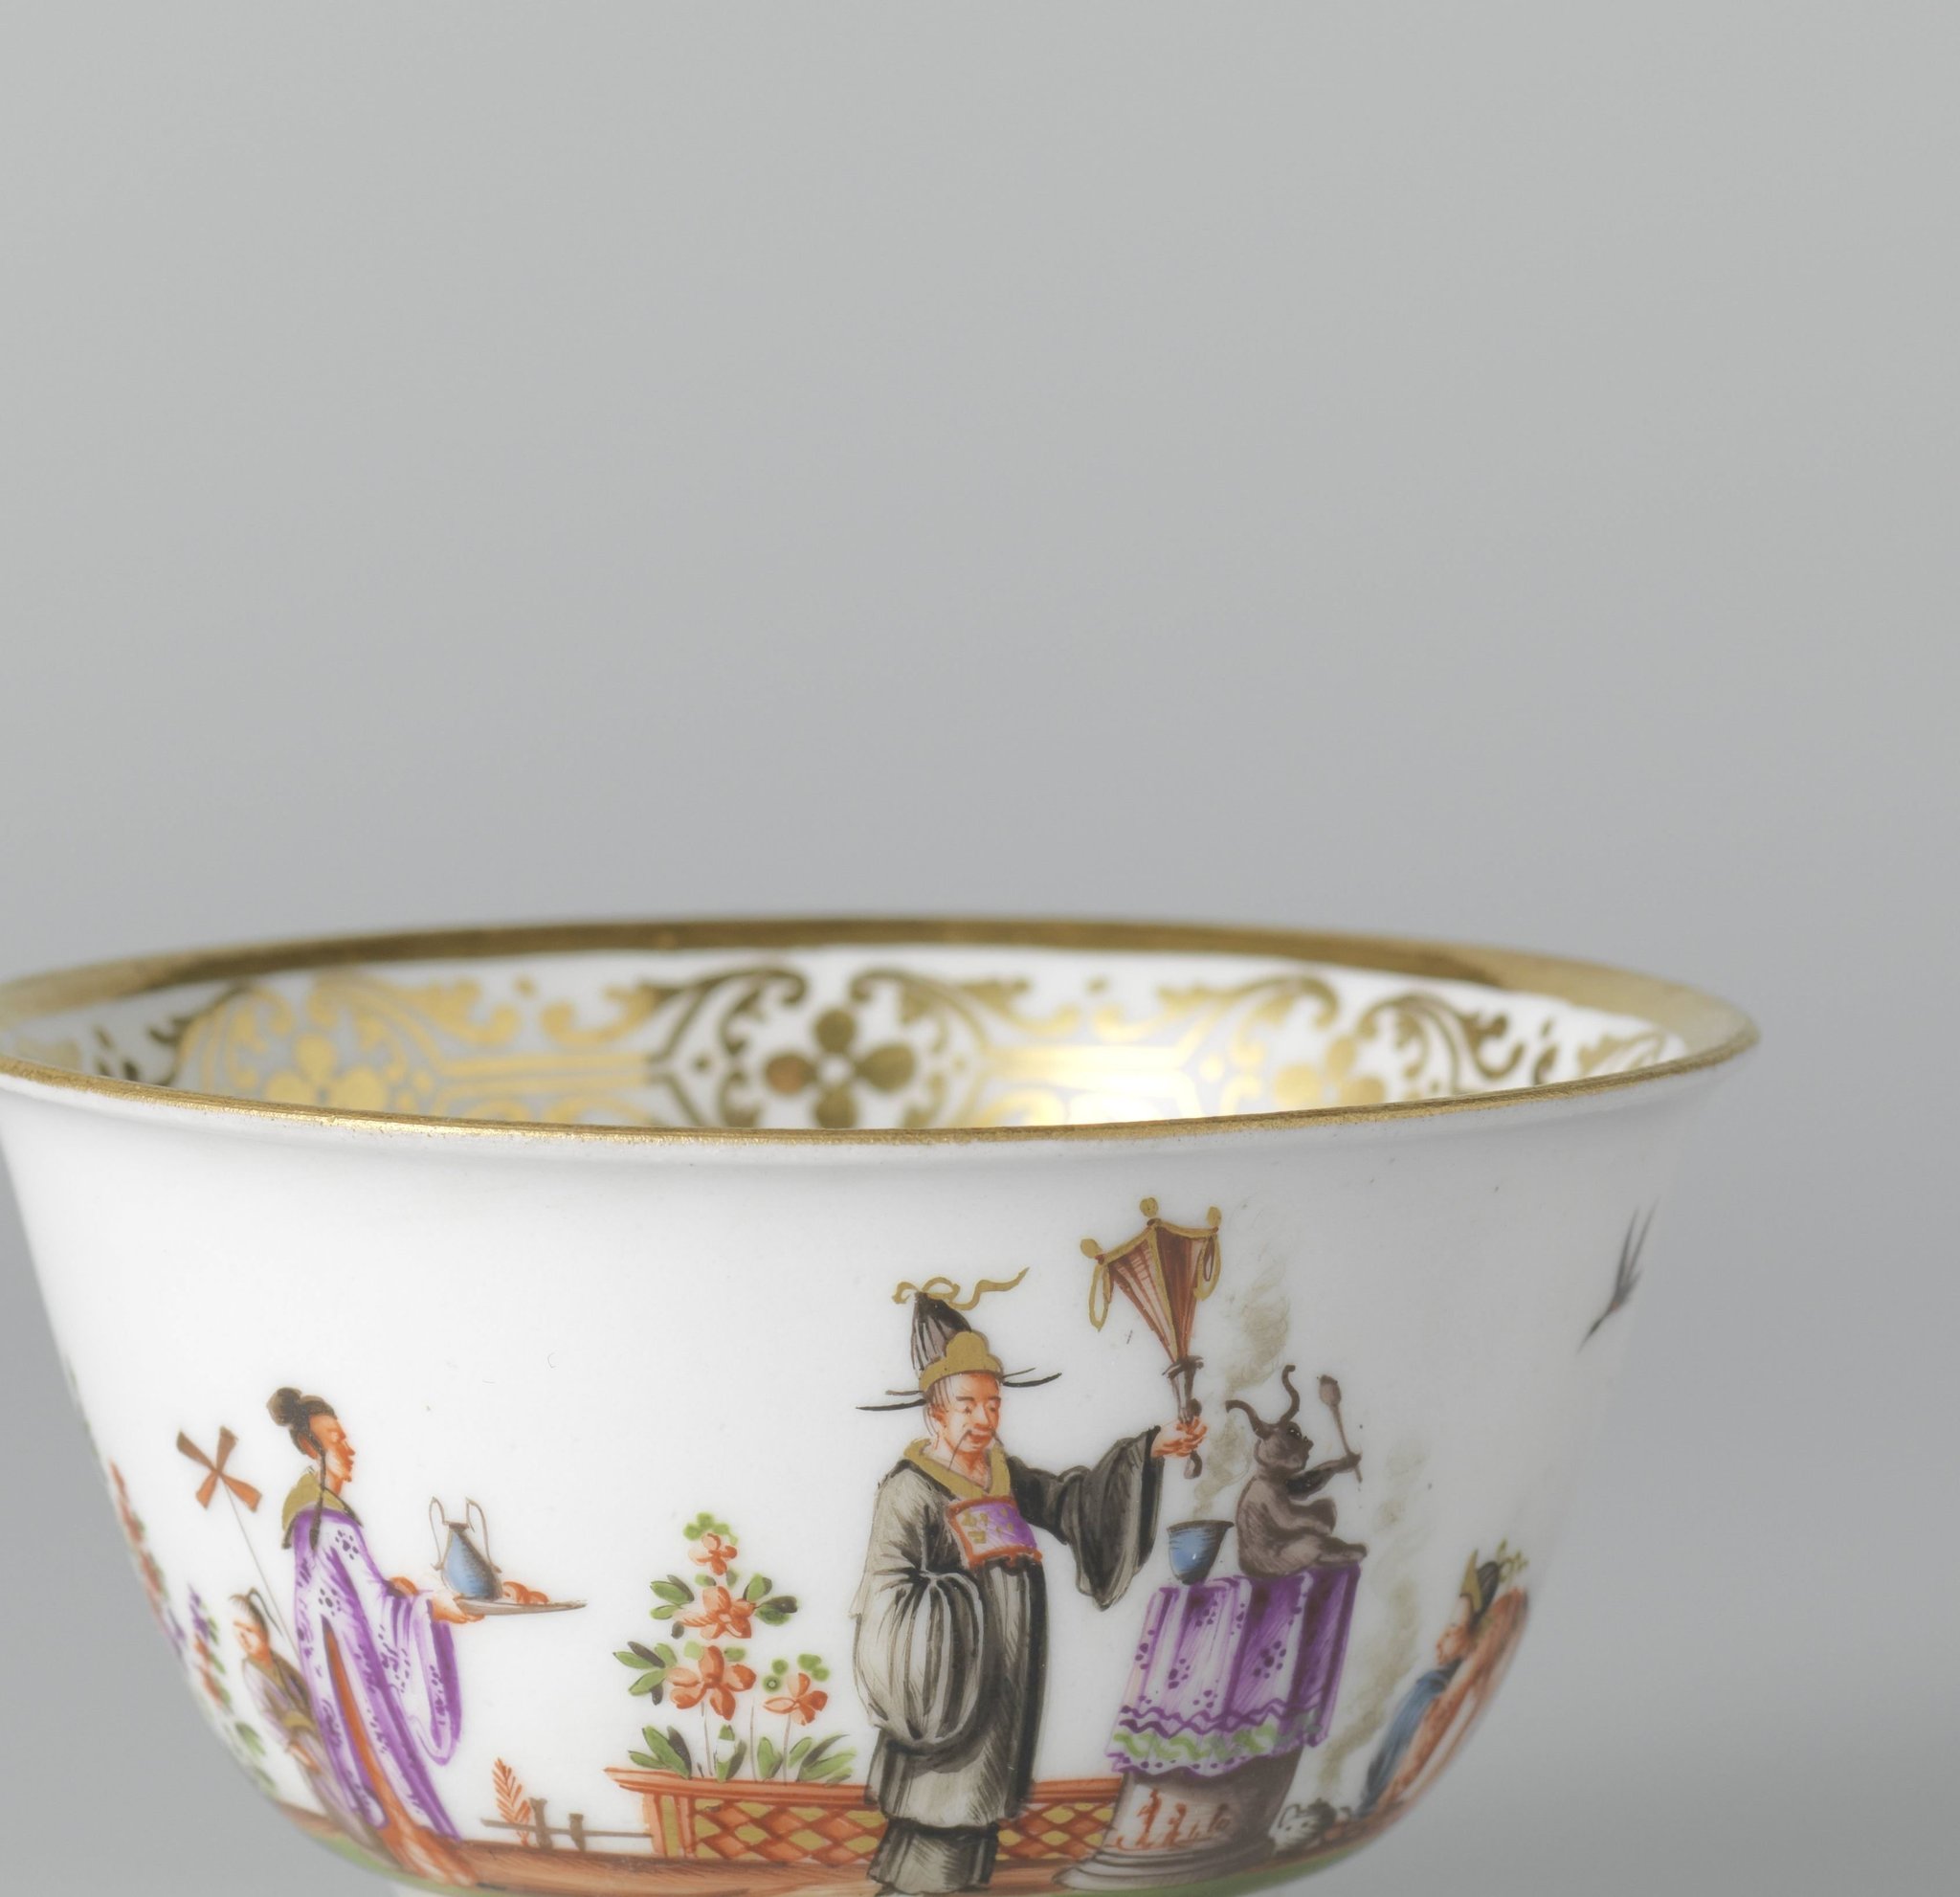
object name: eating drinking utensil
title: Kop, veelkleurig beschilderd met chinoiserieën en het wapen van de Venetiaanse familie Morosini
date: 1731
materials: porcelain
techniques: painted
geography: meissen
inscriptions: factory mark, mark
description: Tea and coffee service with the arms of the Venetian ducal family Morosini. Porcelain in leather travelling case. Meissen, 1731, decorated in the style of Johann Gregorius Höroldt.